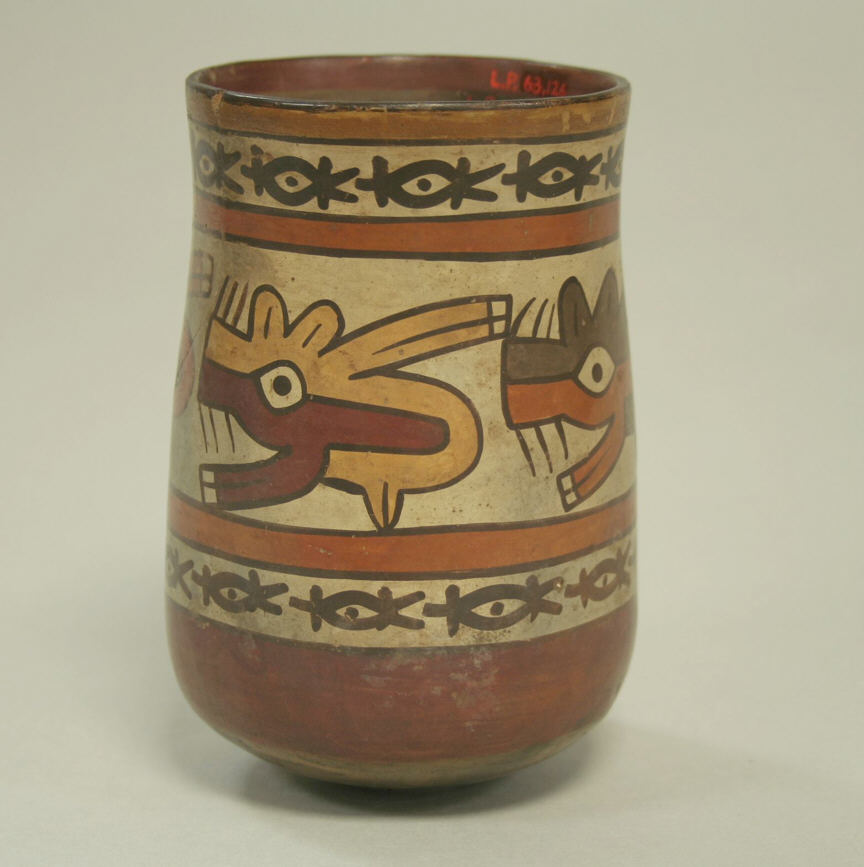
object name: beaker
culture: nasca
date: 1-600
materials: ceramic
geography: peru